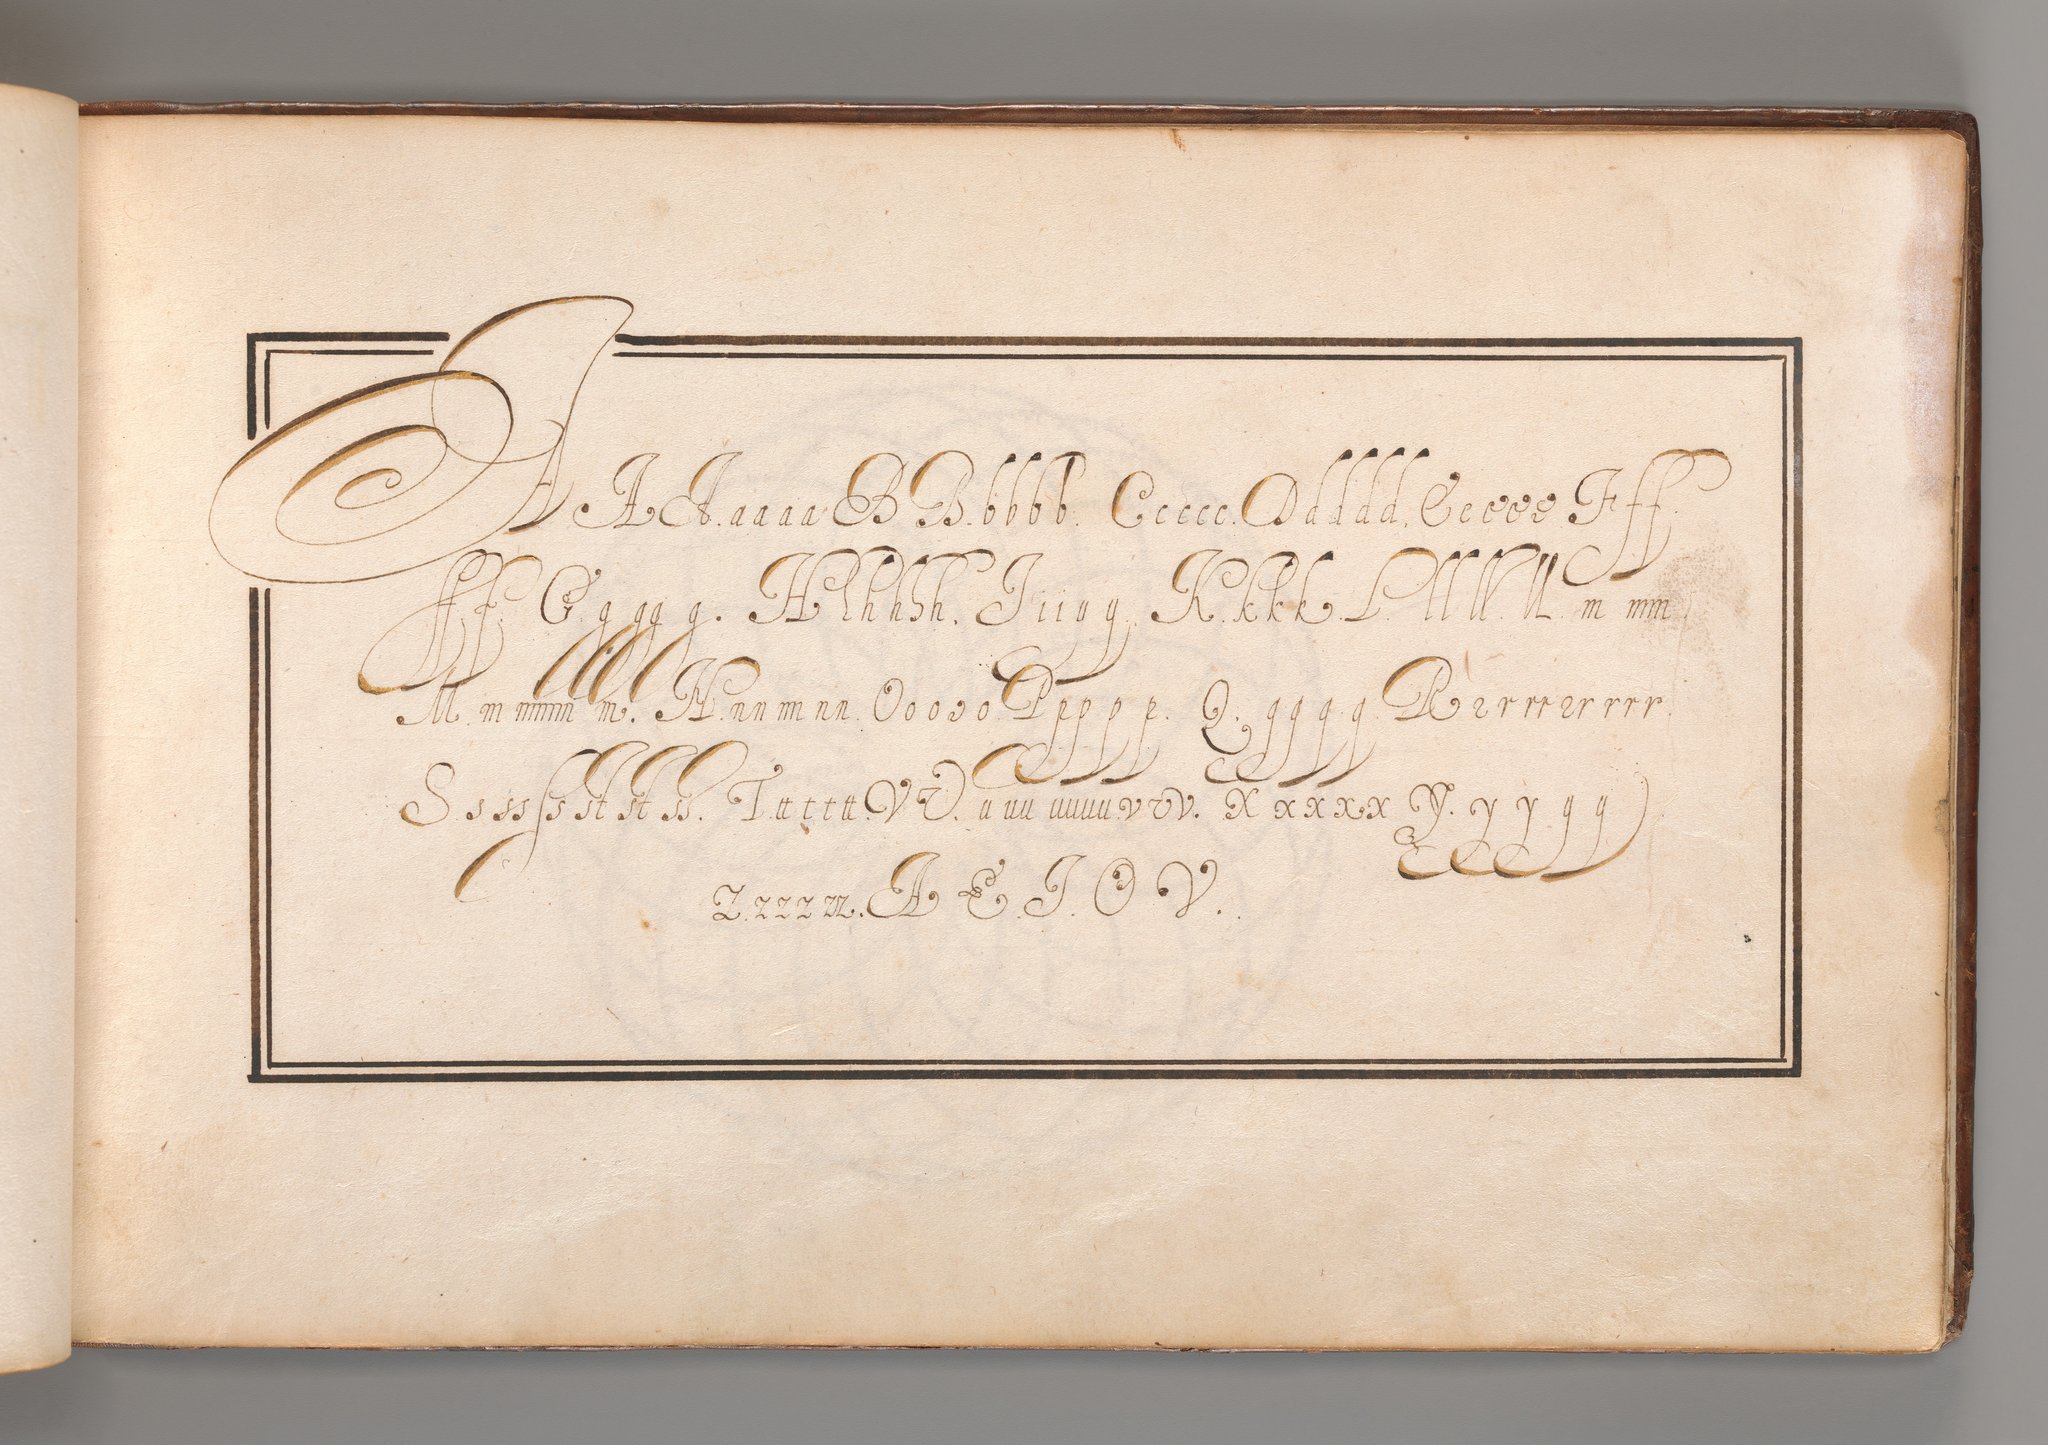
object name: album print ornament architecture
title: Calligraphic Exercise: Letters of the Alphabet in different scripts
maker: Anonymous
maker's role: artist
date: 1601-1633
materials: ink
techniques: pen